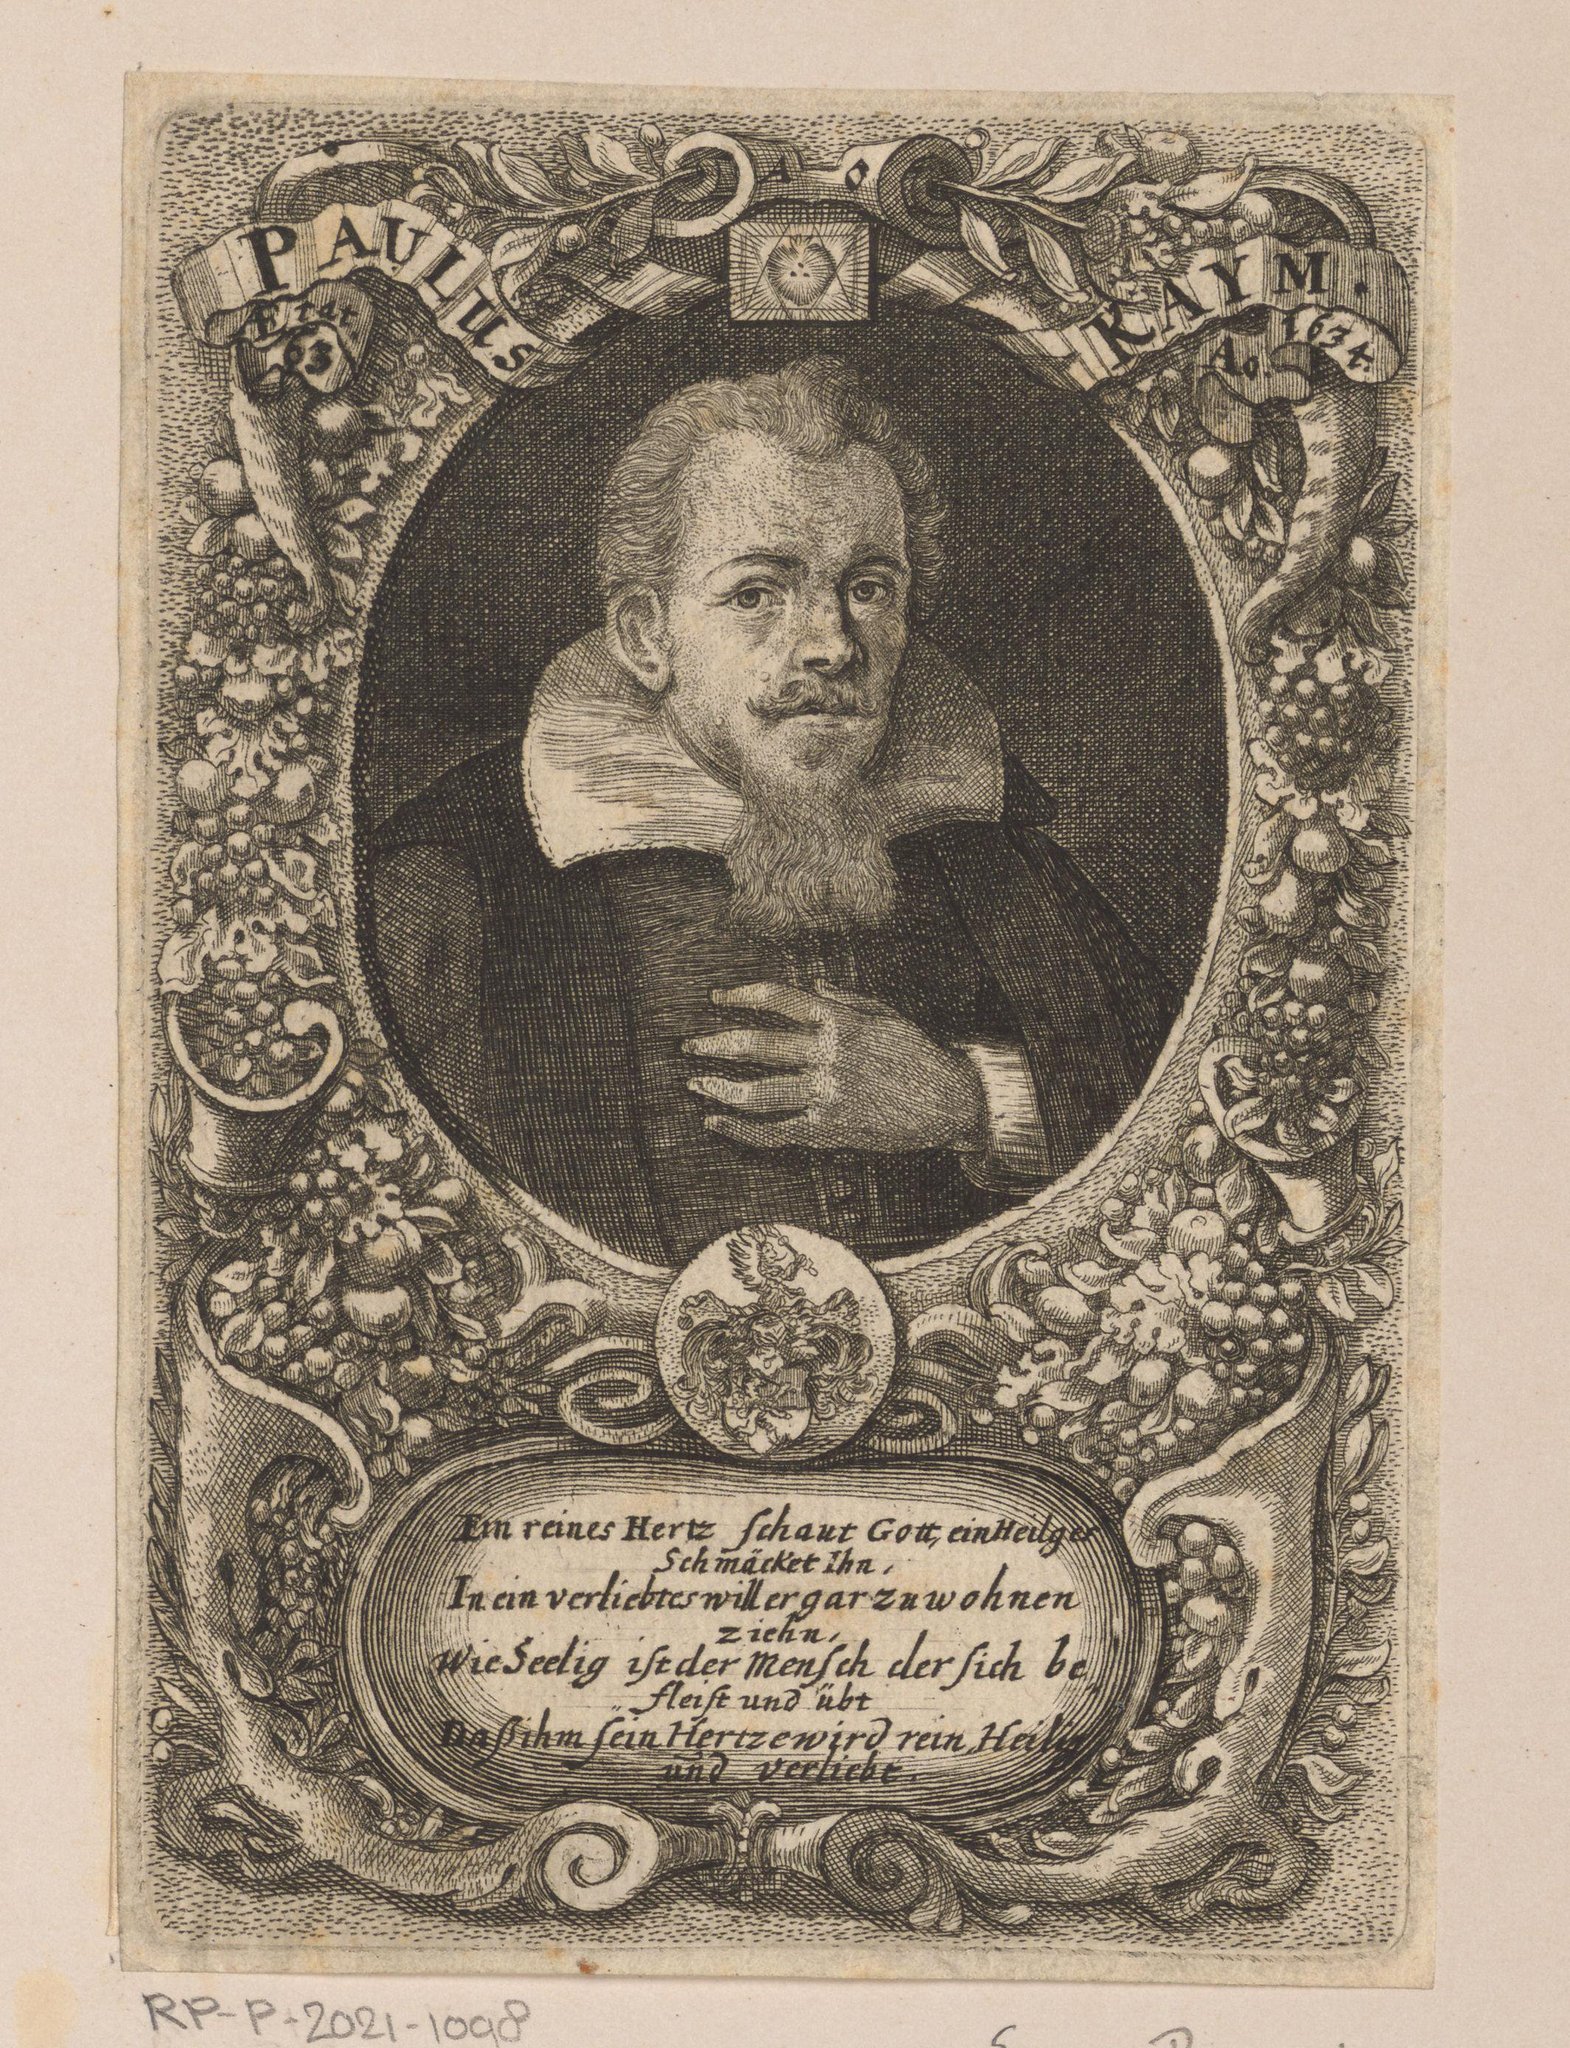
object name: print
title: Portret van Paul Kaym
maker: Anonymous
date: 1634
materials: paper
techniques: etching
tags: historical persons, portrait of a writer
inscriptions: collector's mark: Lugt 2228